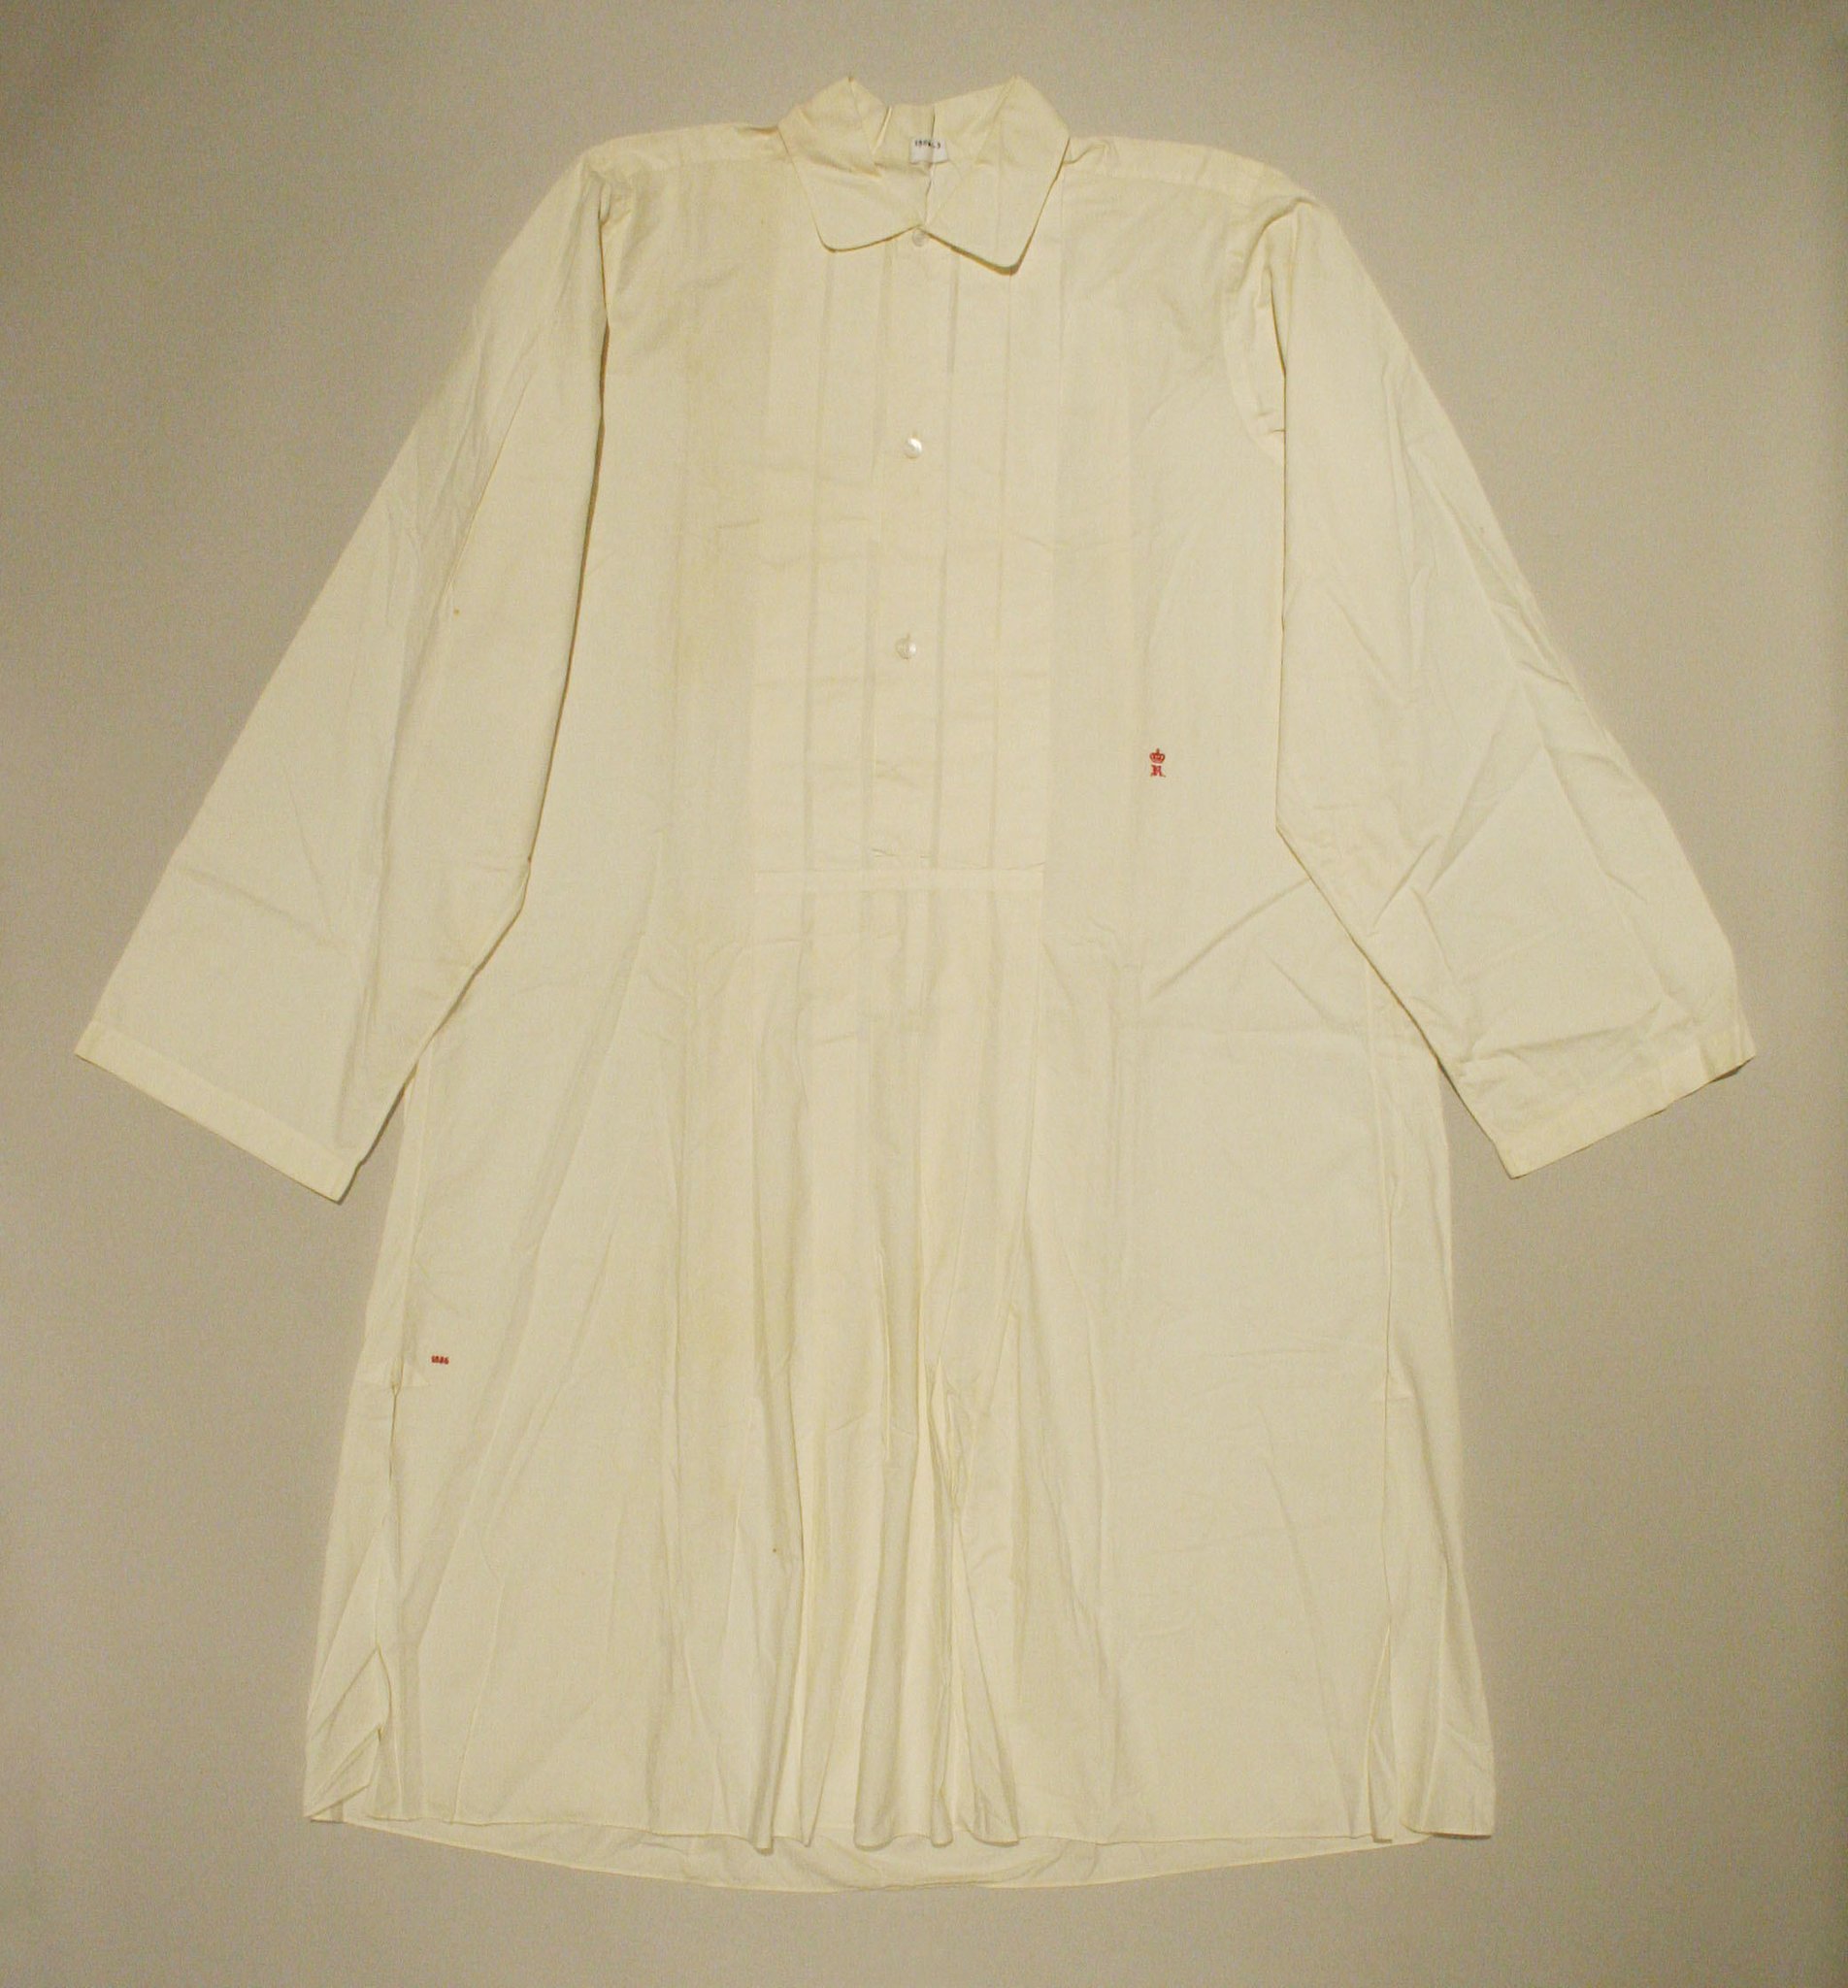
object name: nightshirt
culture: american or european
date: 1886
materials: cotton